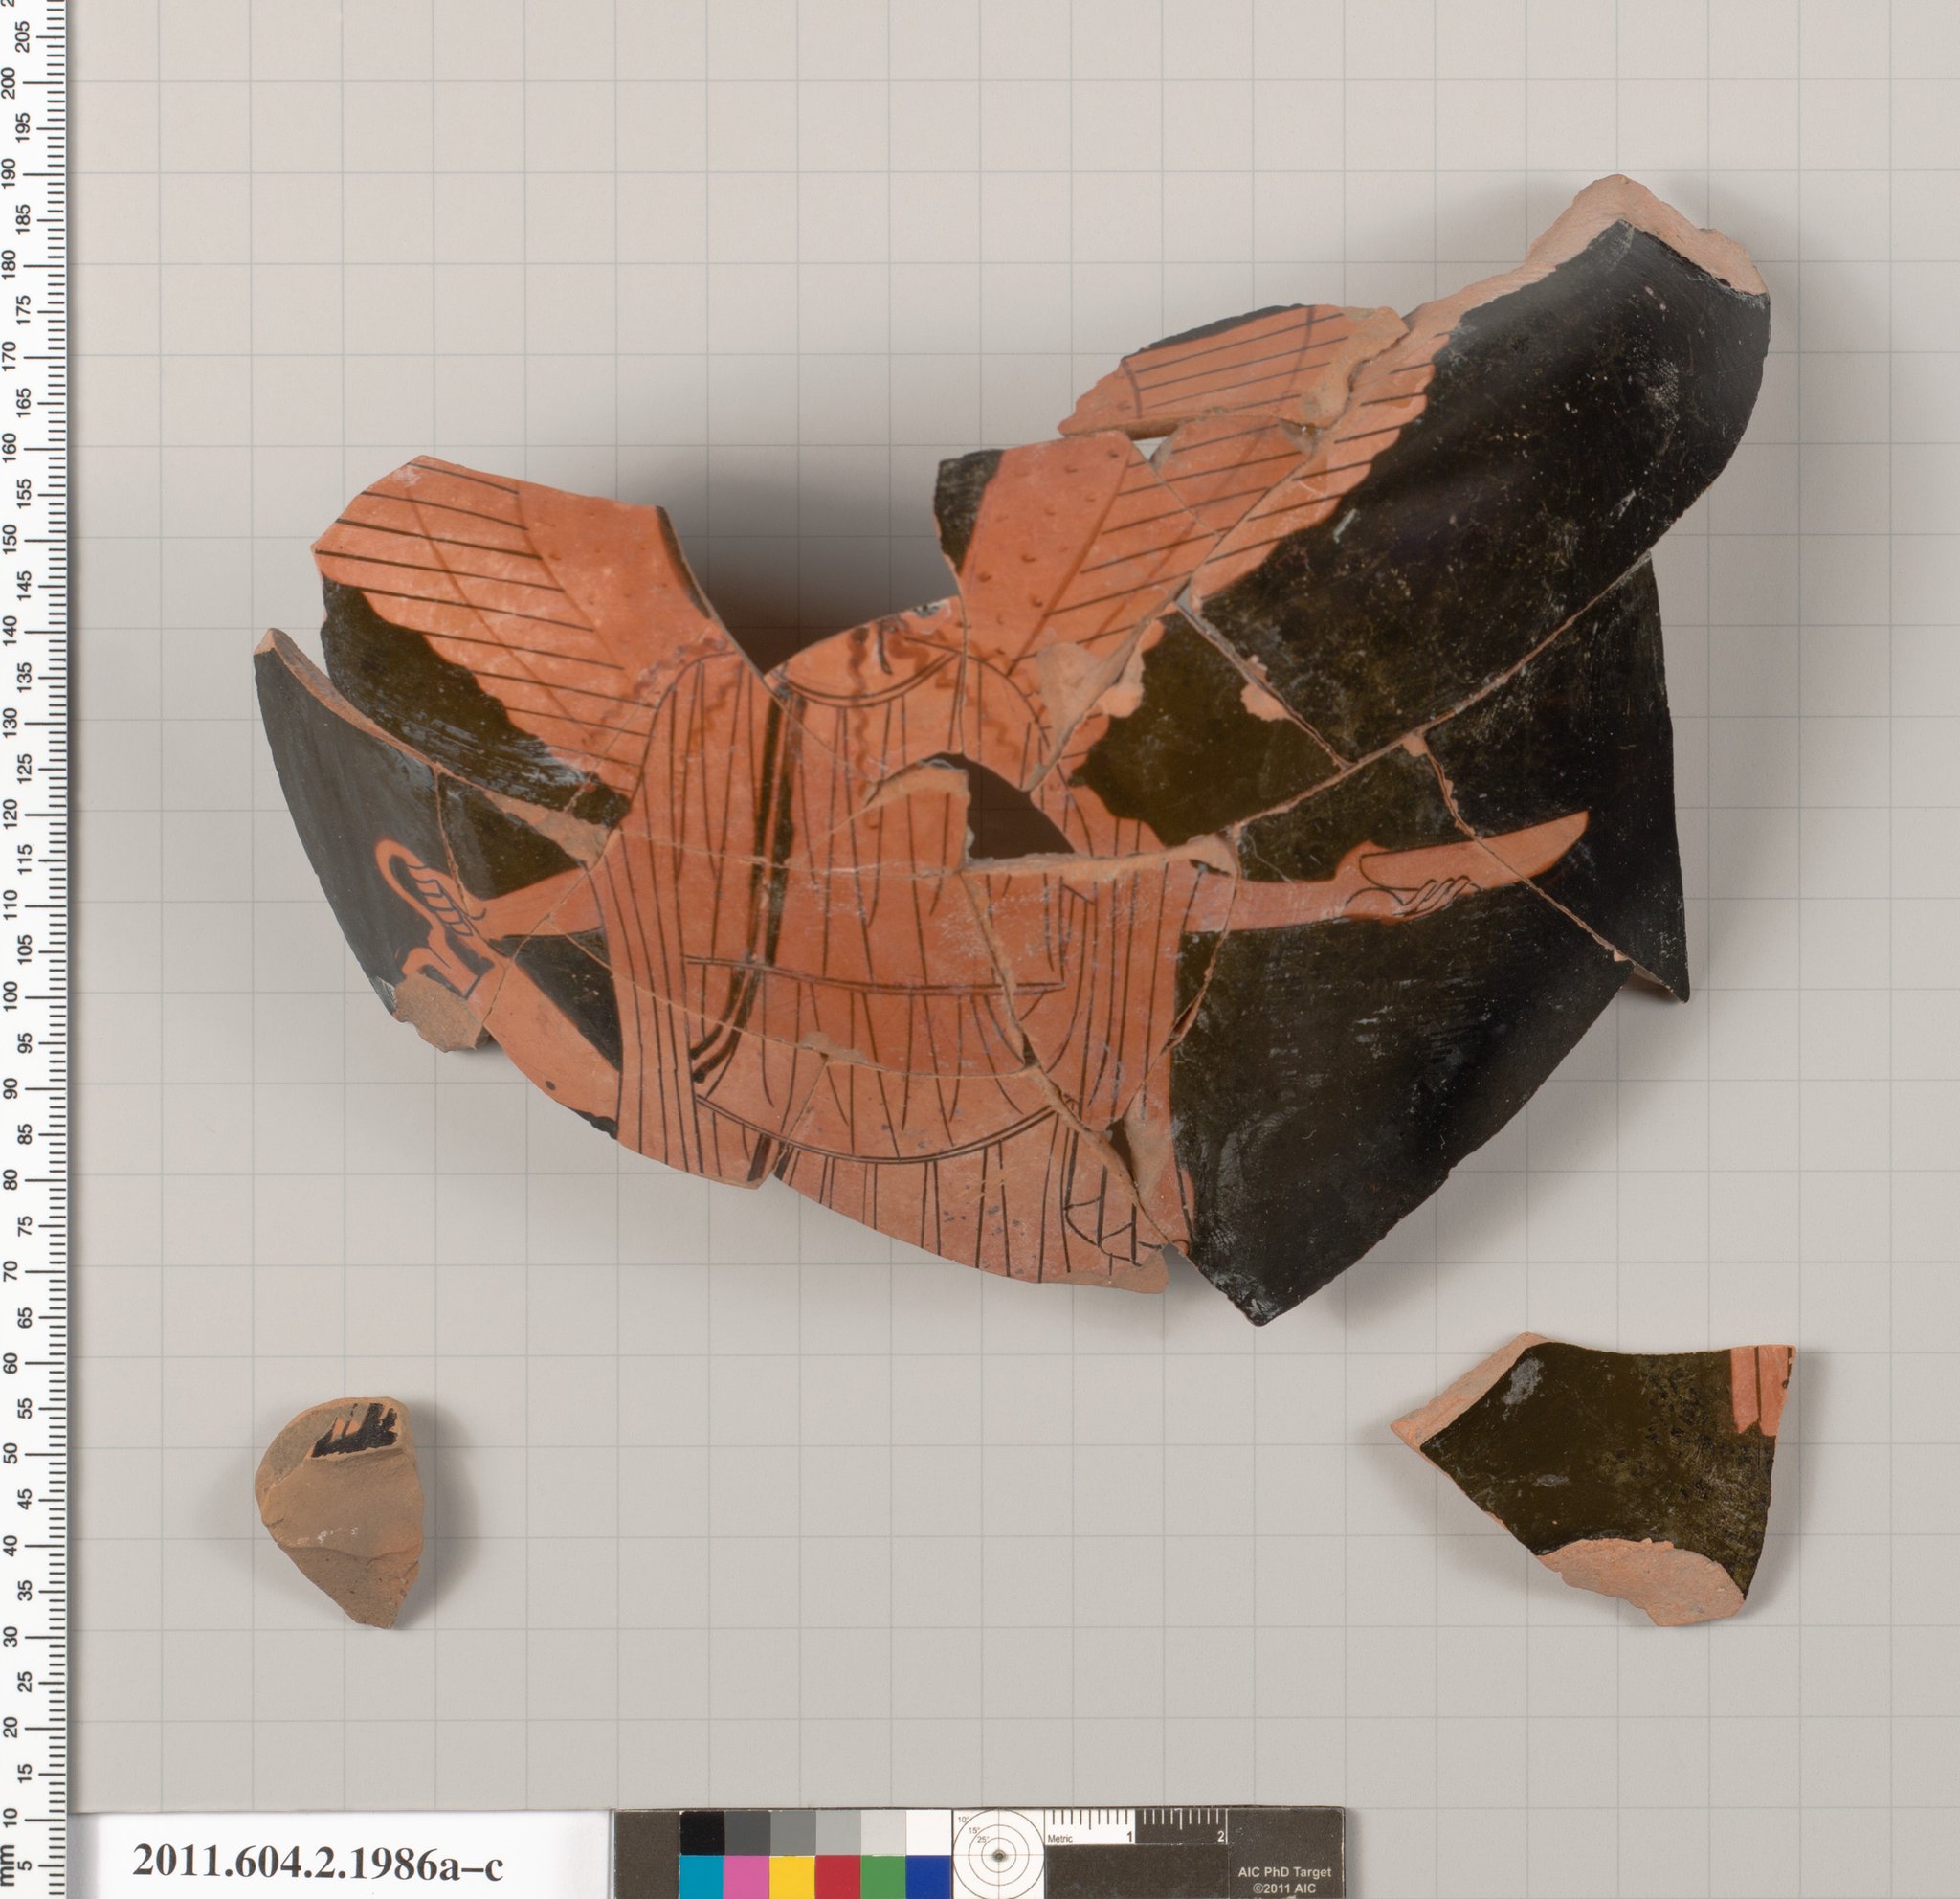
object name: kalpis fragment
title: Terracotta fragments of a hydria: kalpis (water jar)?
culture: greek, attic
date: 470-460 BCE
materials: terracotta